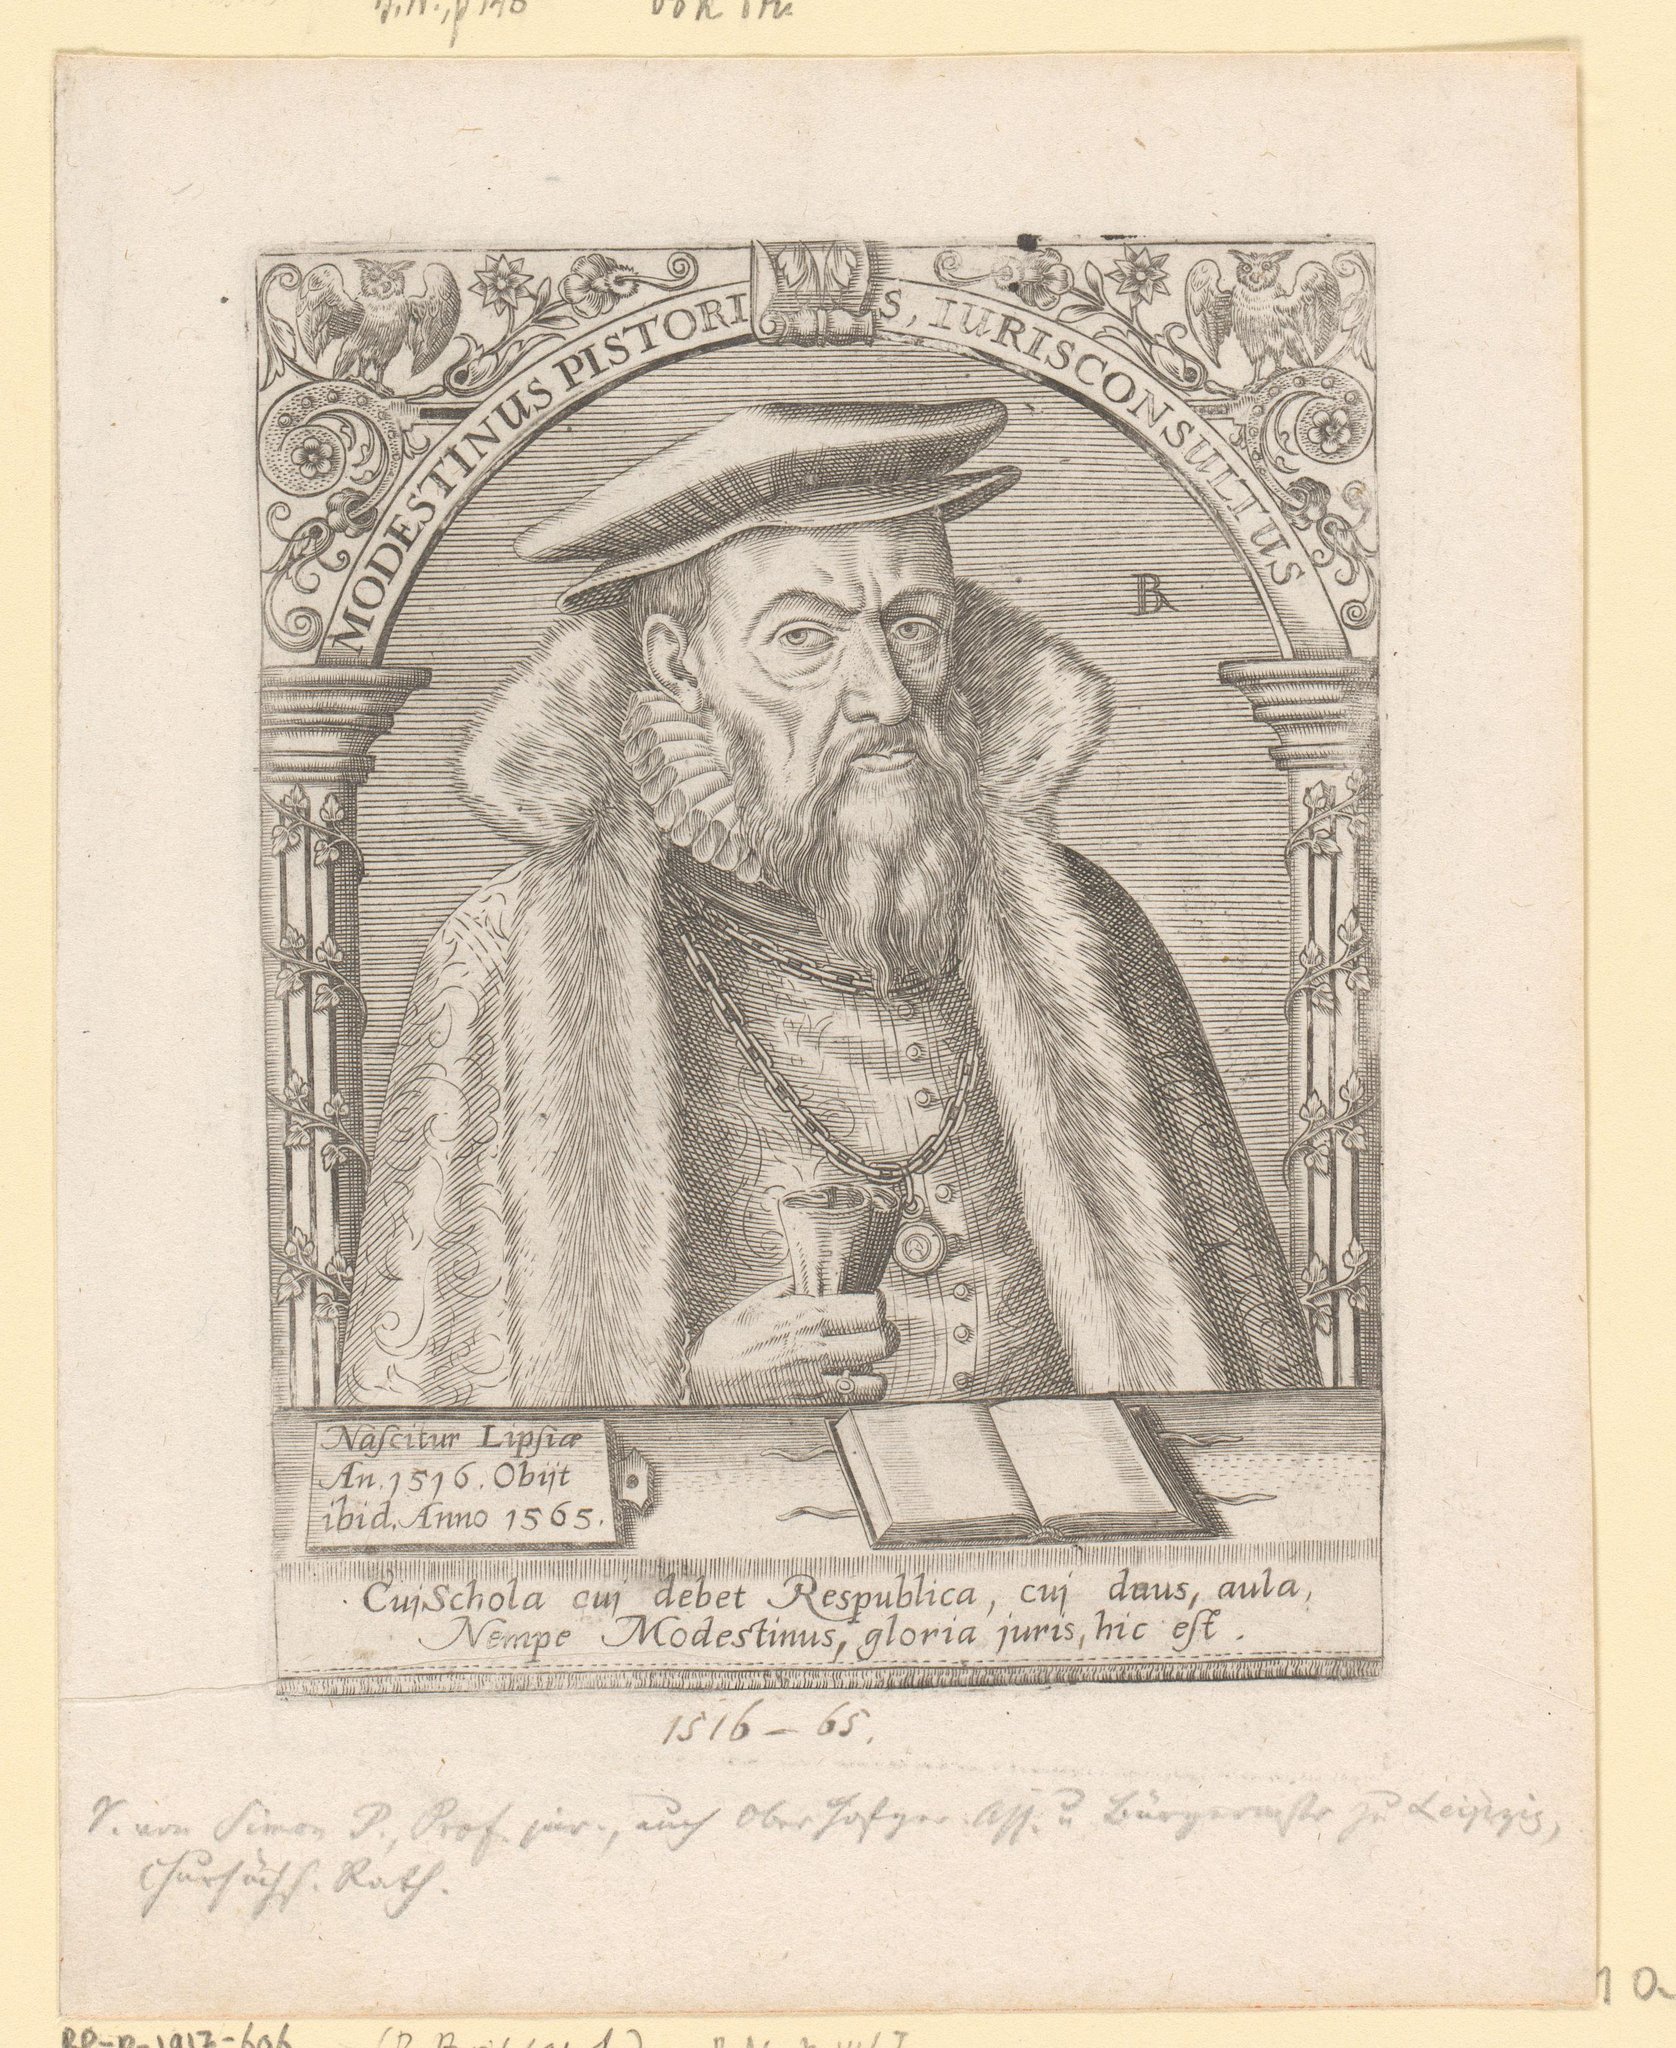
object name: book illustration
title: Portret van Modestinus Pistoris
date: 1598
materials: paper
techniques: engraving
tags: mayor, mayor, burgomaster, historical persons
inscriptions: inscription: ‘1516-65.’, collector's mark: Lugt 2228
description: Prent gebruikt in: Boissard, Jean Jacques. Icones quinquaginta virorum illustrium doctrina & eruditione praestantium ad vivum effictae. 4 dln. Frankfurt am Main: s.n., 1597-1599. Mogelijk ook gebruikt in latere edities. Latere staat van prent verschenen in: Boissard, Jean Jacques. Bibliotheca chalcographica. 8 dln. Frankfurt am Main: Johannes Ammon, 1650-1652. Ook gebruikt in latere edities.